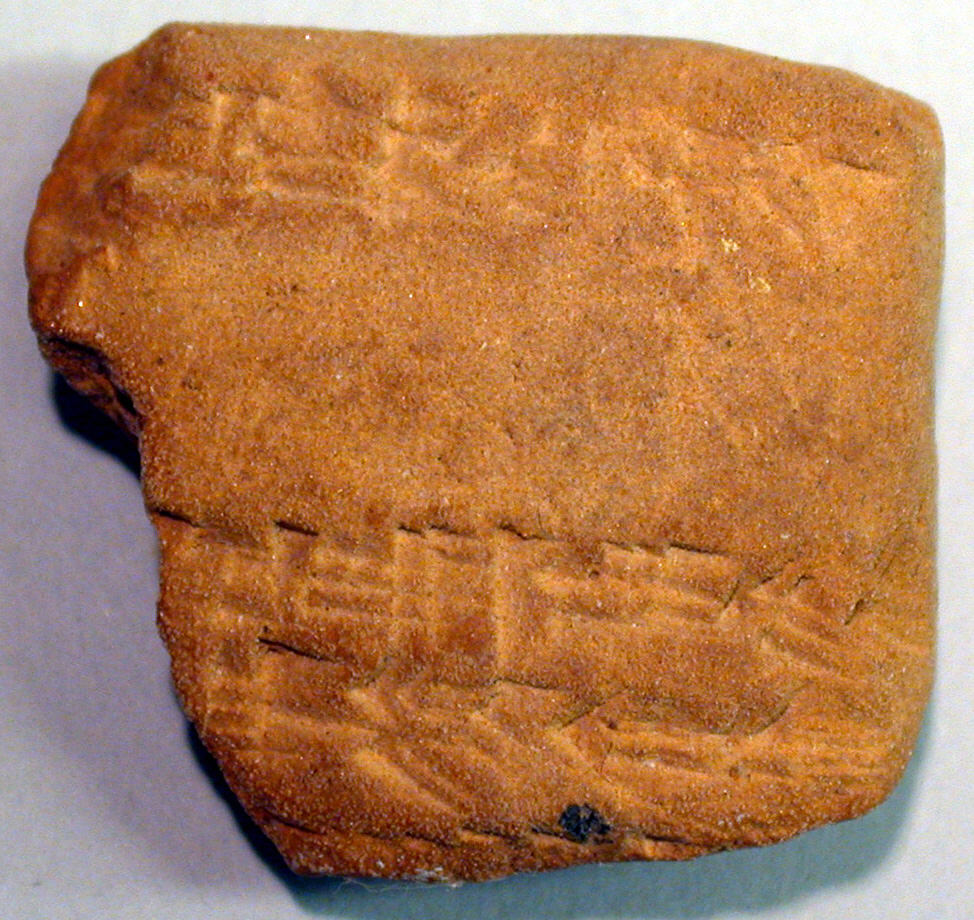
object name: cuneiform tablet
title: Cuneiform tablet: fragment, Ebabbar archive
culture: achaemenid or babylonian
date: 700-301 BCE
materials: clay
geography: mesopotamia